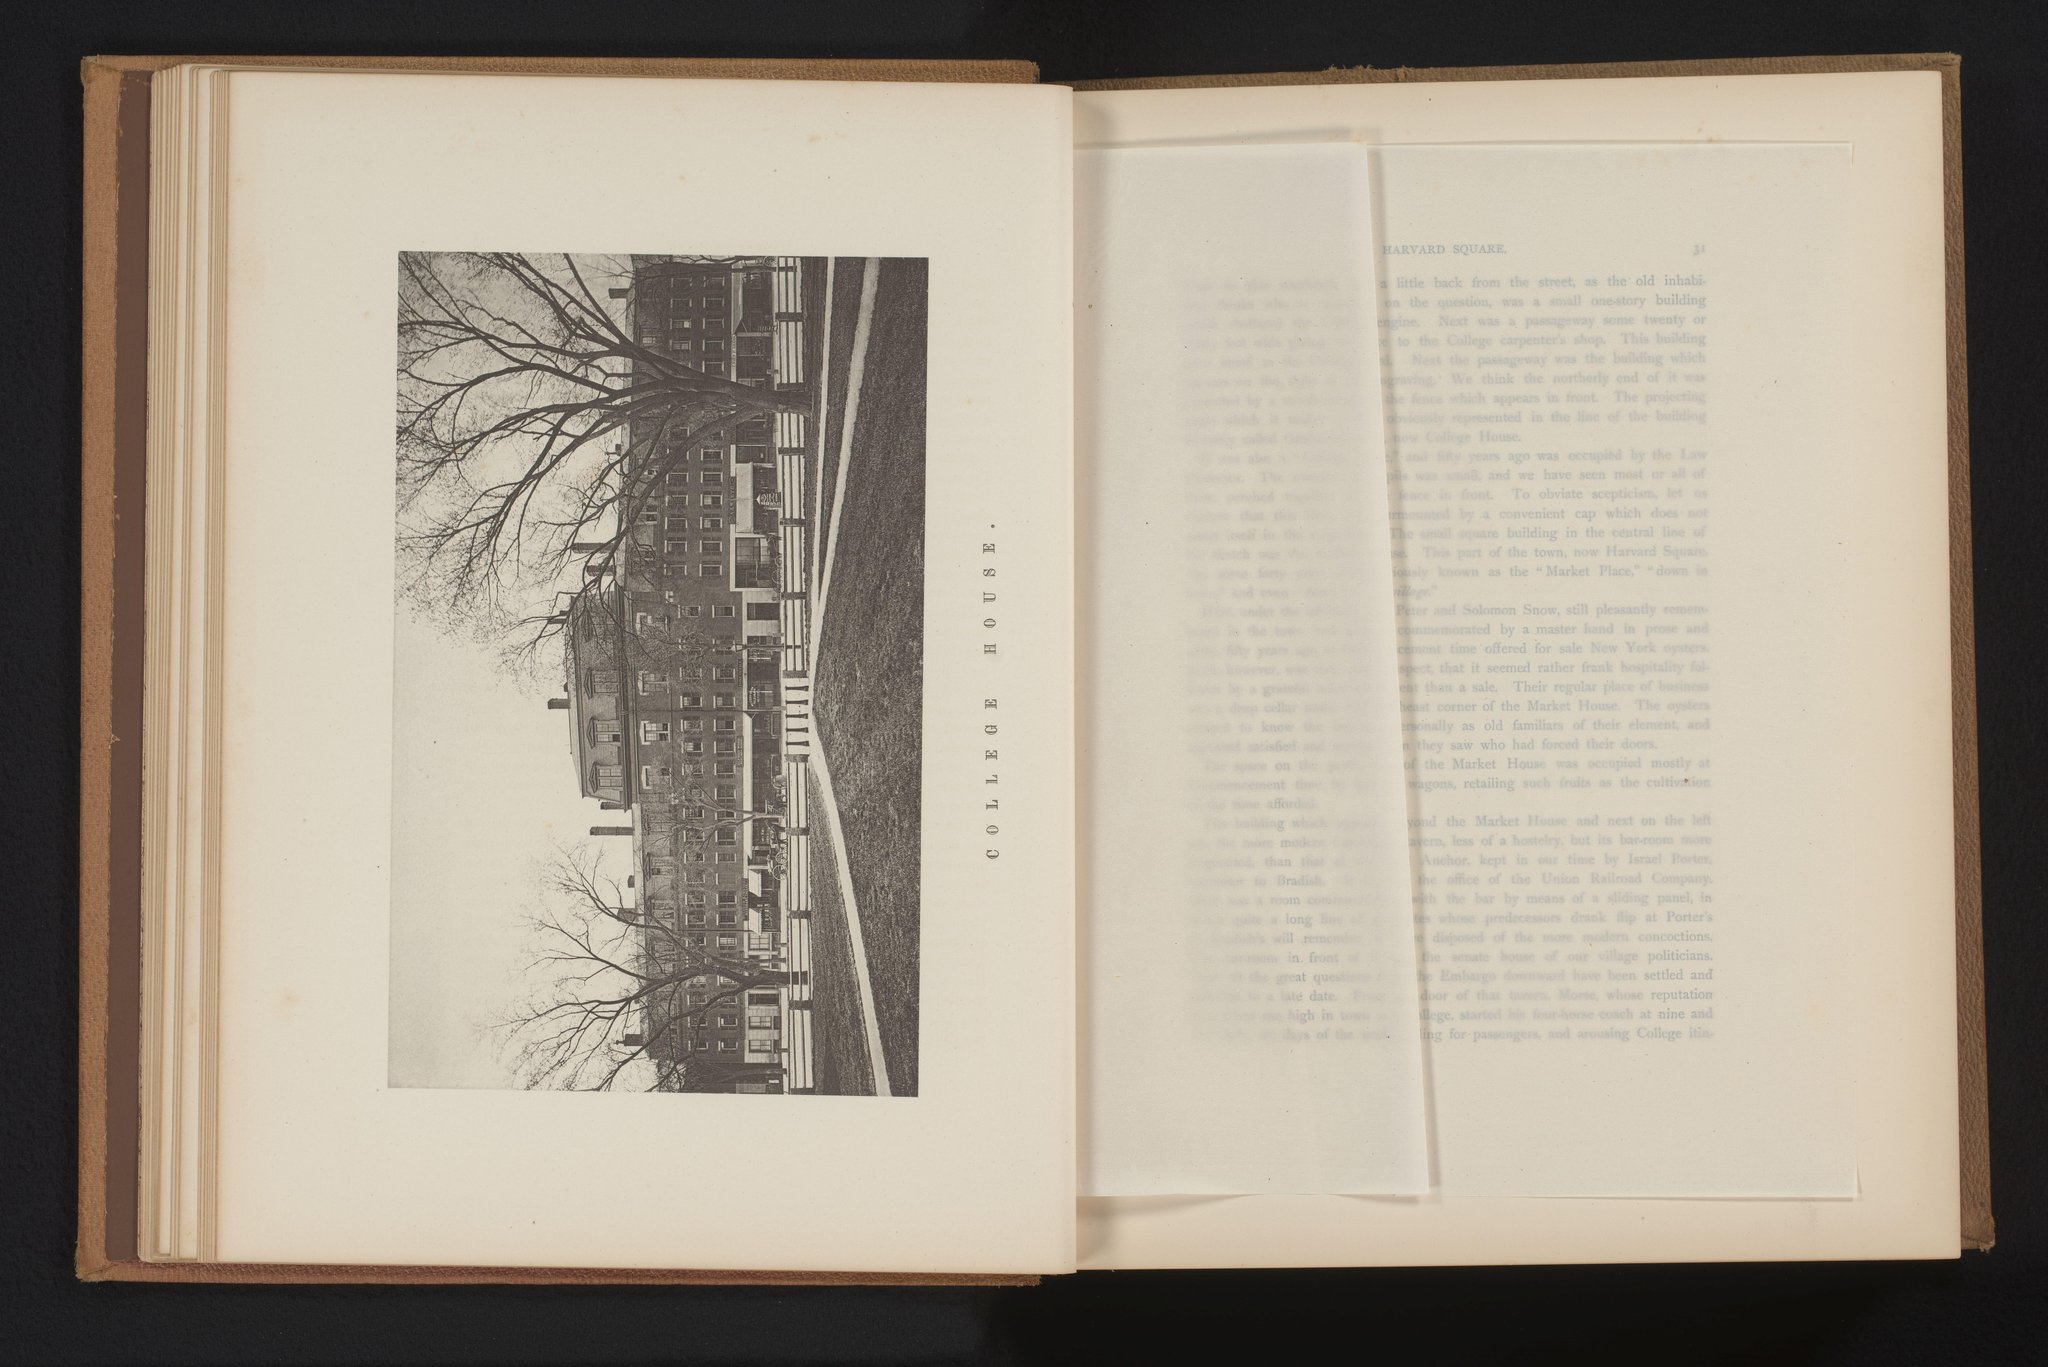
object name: photomechanical print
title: Gezicht op een gebouw van de Harvard-universiteit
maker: Anonymous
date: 1870-1875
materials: paper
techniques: photograph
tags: university building, college